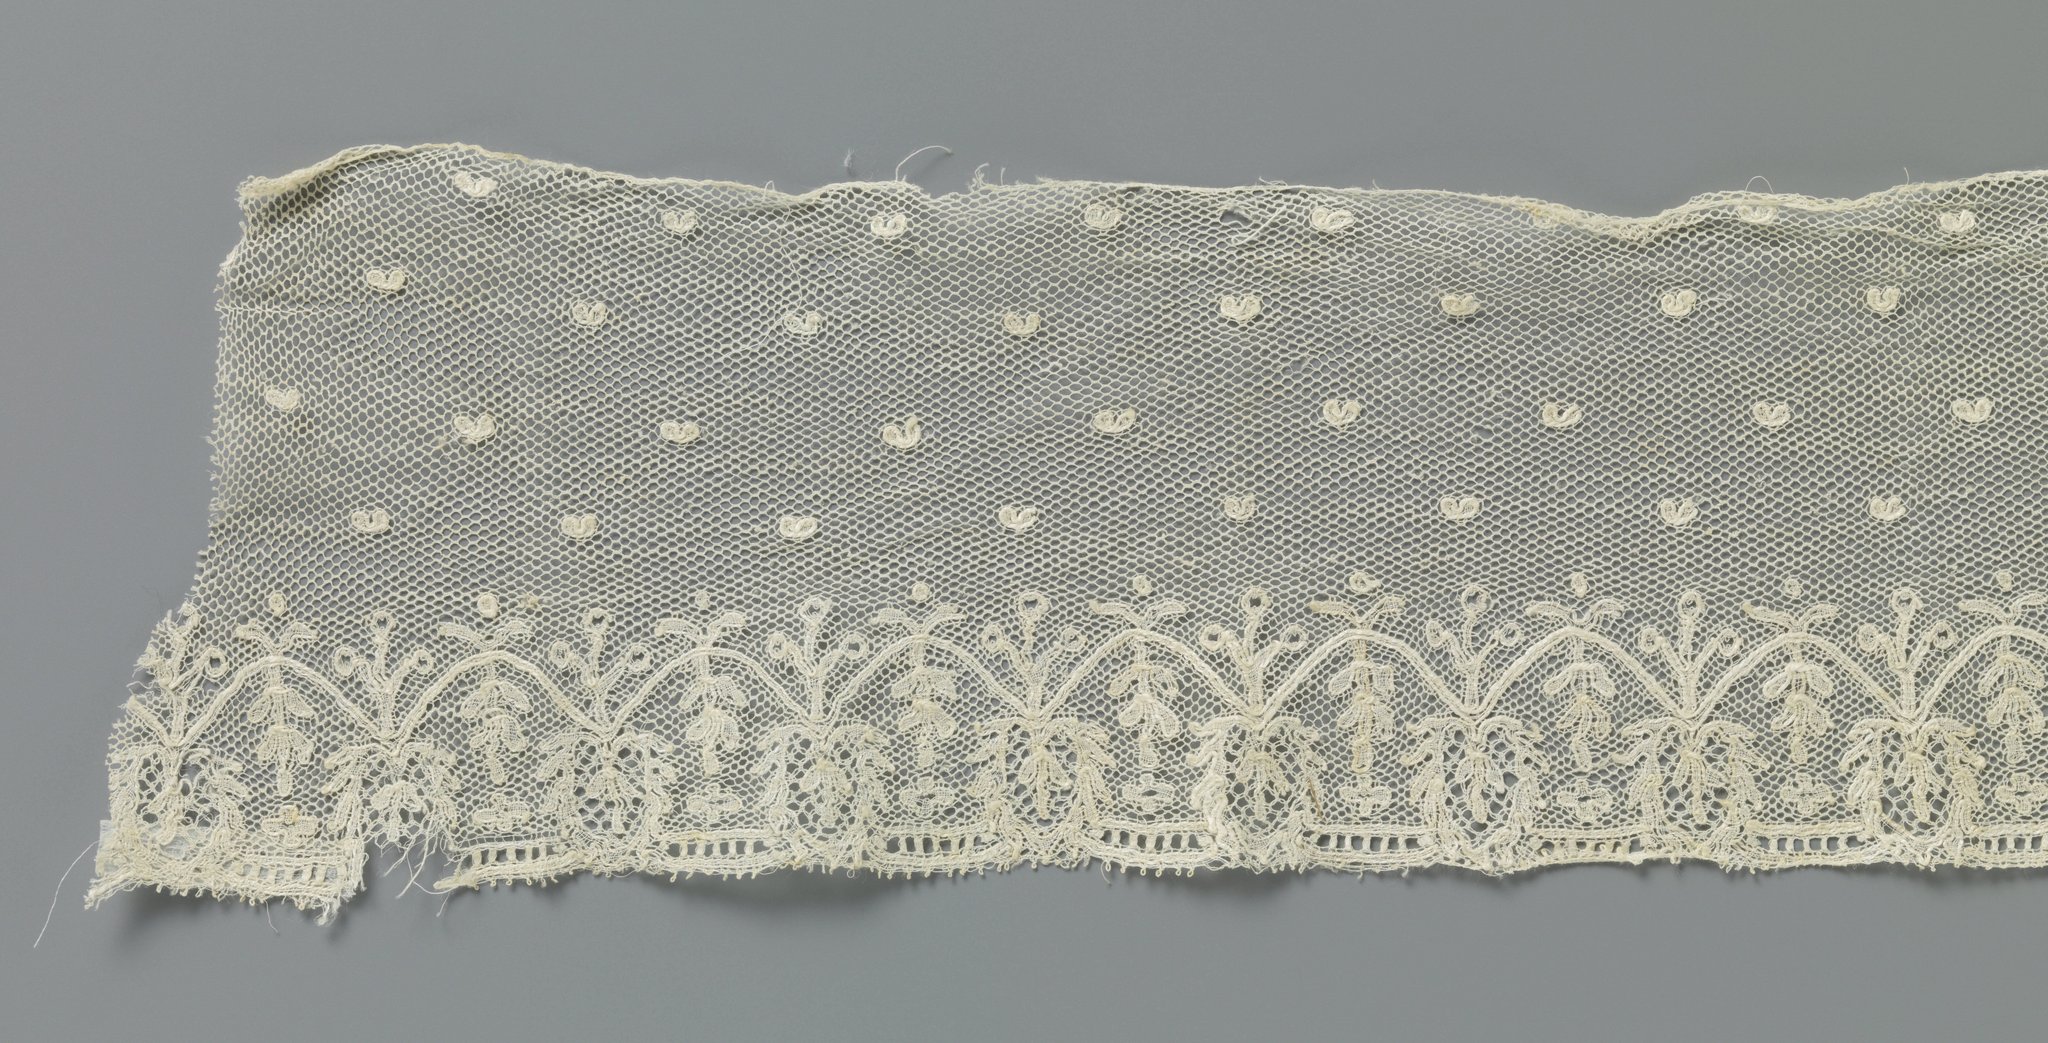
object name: strip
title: Strook kloskant met hartjes strooipatroon en dennenappelmotief onder ijle zigzag-lijn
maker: Anonymous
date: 1800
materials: linen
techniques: lace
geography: mechelen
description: Strook naturelkleurige kloskant: Mechelse kant. Onder een strooipatroon van vier rijen hartjes loopt een ijle zigzag-lijn, met onder elk zigzag-dal een dennenappelvormig motief dat tot aan de onderzijde van de strook naar beneden hangt. Tussen de dennenappelmotieven ligt een opengewerkt sierrandje langs de onderzijde van de strook, versierd met blokjes gemaakt in vormslag. De motieven zijn met elkaar verbonden door een fijne maasgrond, een Mechelse grond. Het spaarzame volwerk is gemaakt in linnenslag met dikkere en glimmende contourdraden. De boven- en onderzijde van de strook zijn recht afgewerkt, waarbij de onderzijde is voorzien van picots.